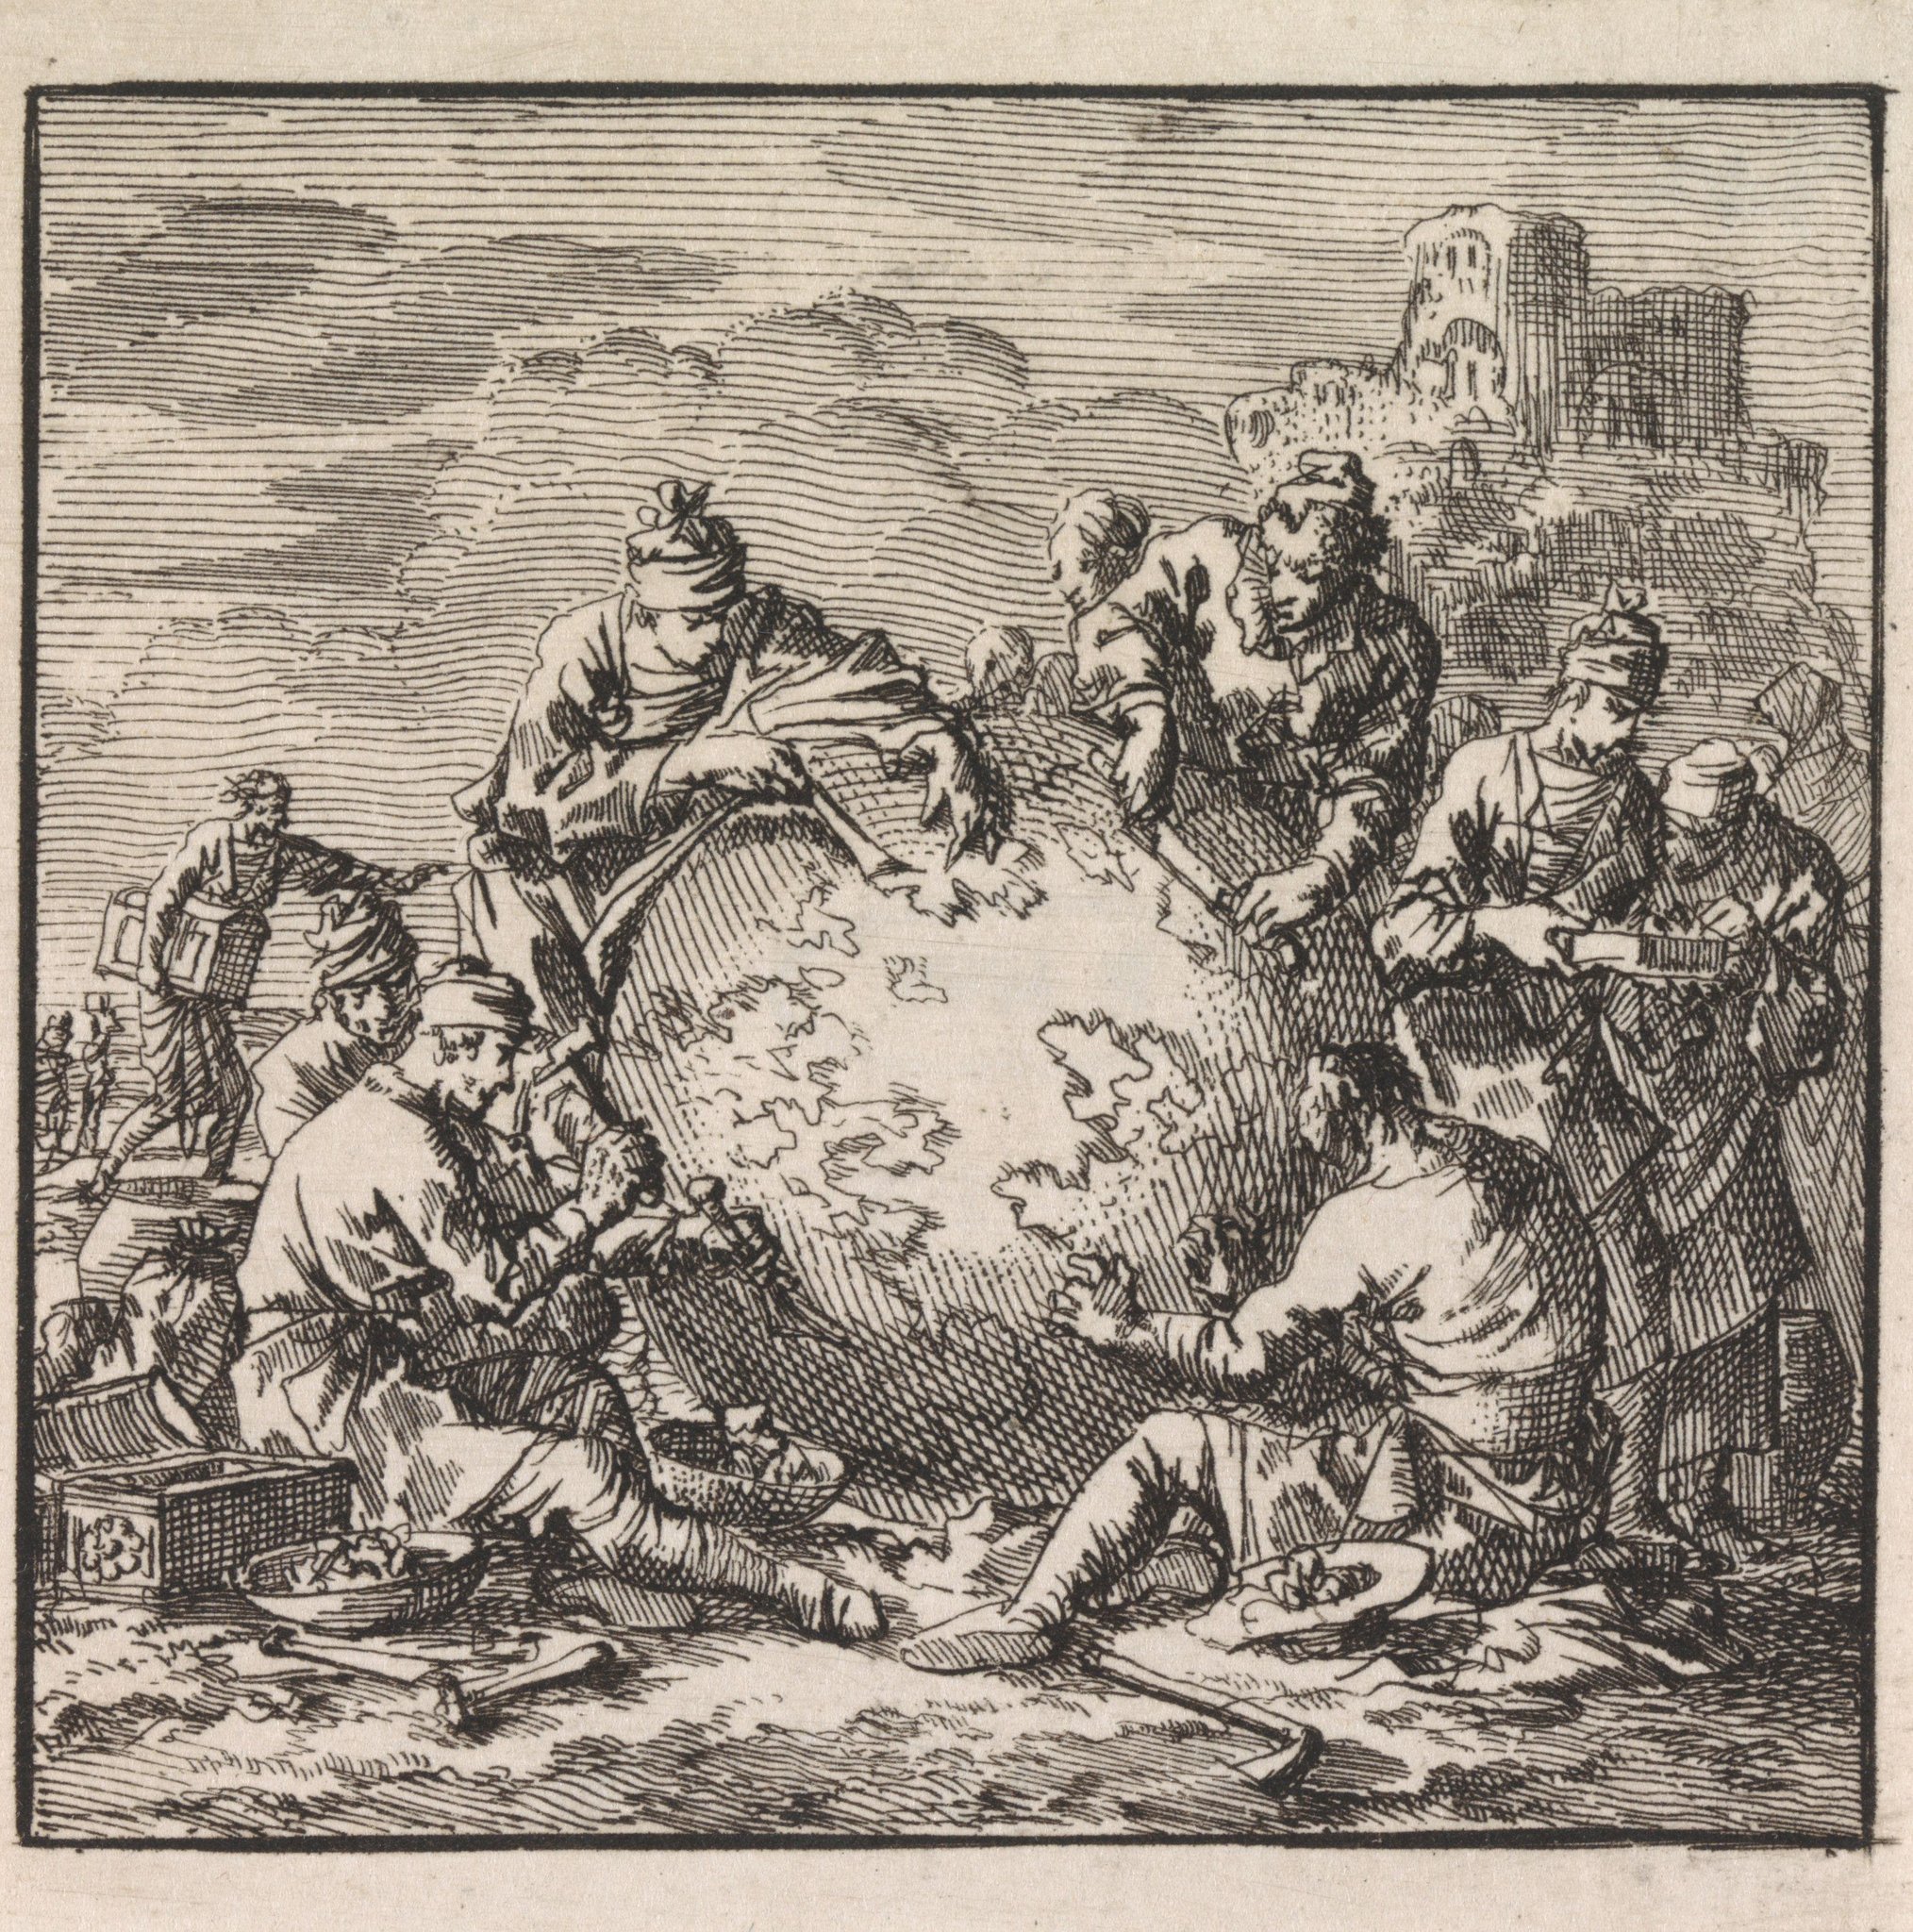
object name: print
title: Enkele figuren trachten voor zichzelf een stuk van de wereldbol te bemachtigen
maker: jan luyken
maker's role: draughtsman, print maker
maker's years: 1649-1712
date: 1710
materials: paper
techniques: etching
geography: amsterdam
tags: earth, world as celestial body, tools, aids, implements ~ crafts and industries: chisel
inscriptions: collector's mark: Lugt 2228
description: Proefdruk voor illustratie uit: Luyken, Jan. De onwaardige wereld, vertoond in vyftig zinnebeelden, met godlyke spreuken en stichtelyke verzen. Amsterdam: Pieter Arentsz. II (wed.) en Cornelis van der Sys, 1710, p. 172.